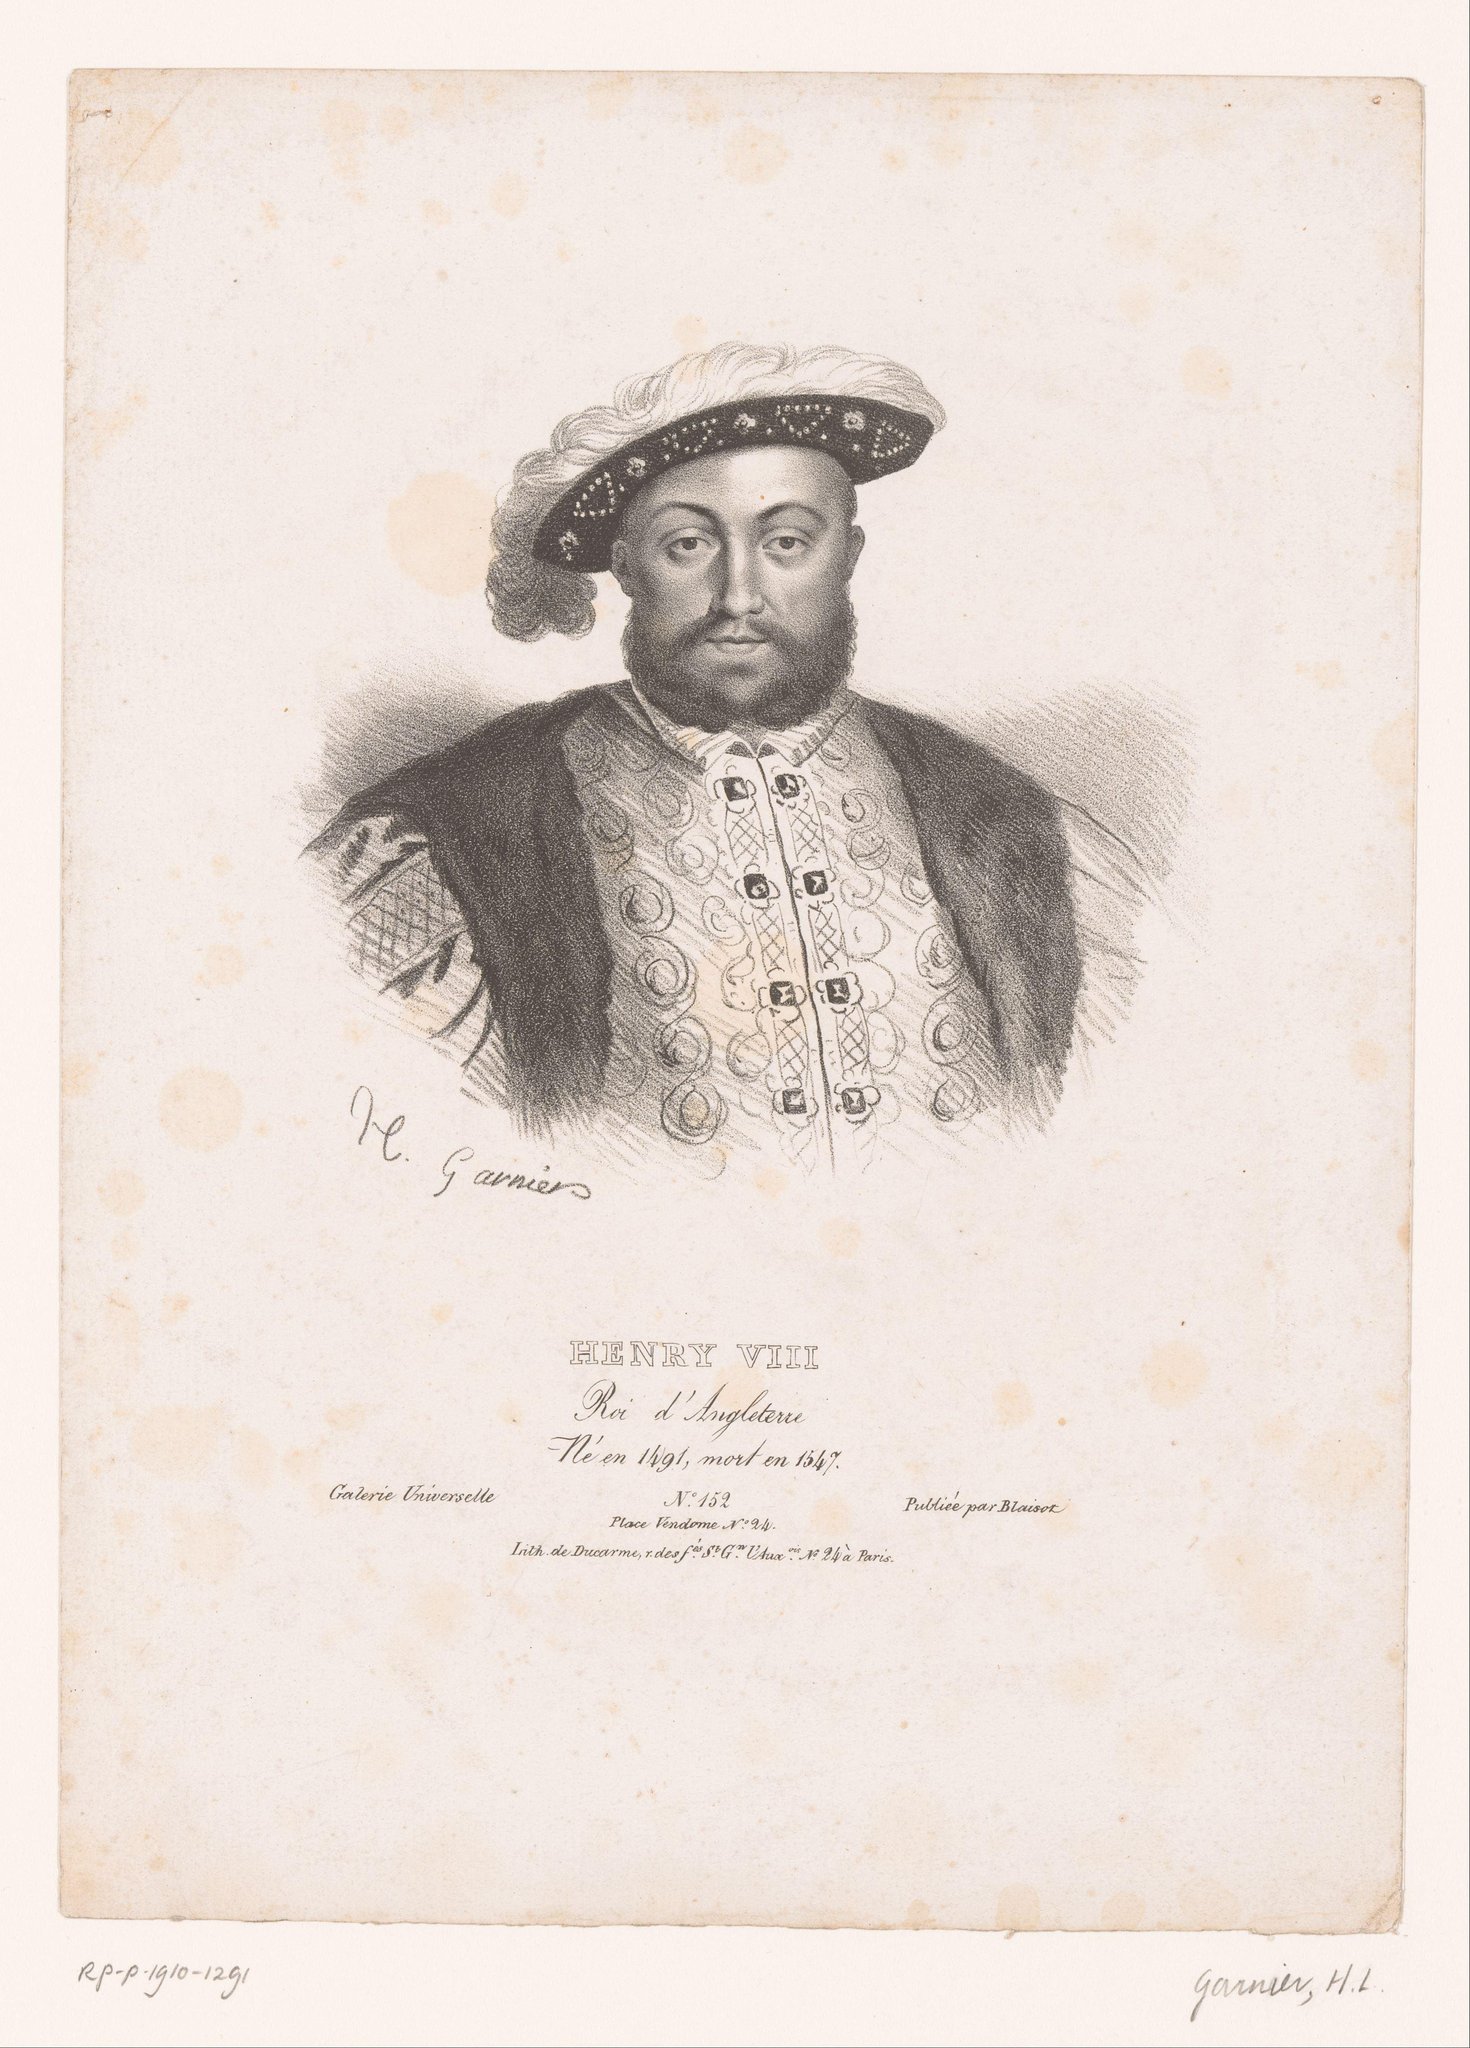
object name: print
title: Portrettengalerij van Blaisot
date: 1823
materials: paper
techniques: lithograph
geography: paris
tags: historical persons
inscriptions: collector's mark: Lugt 2228a